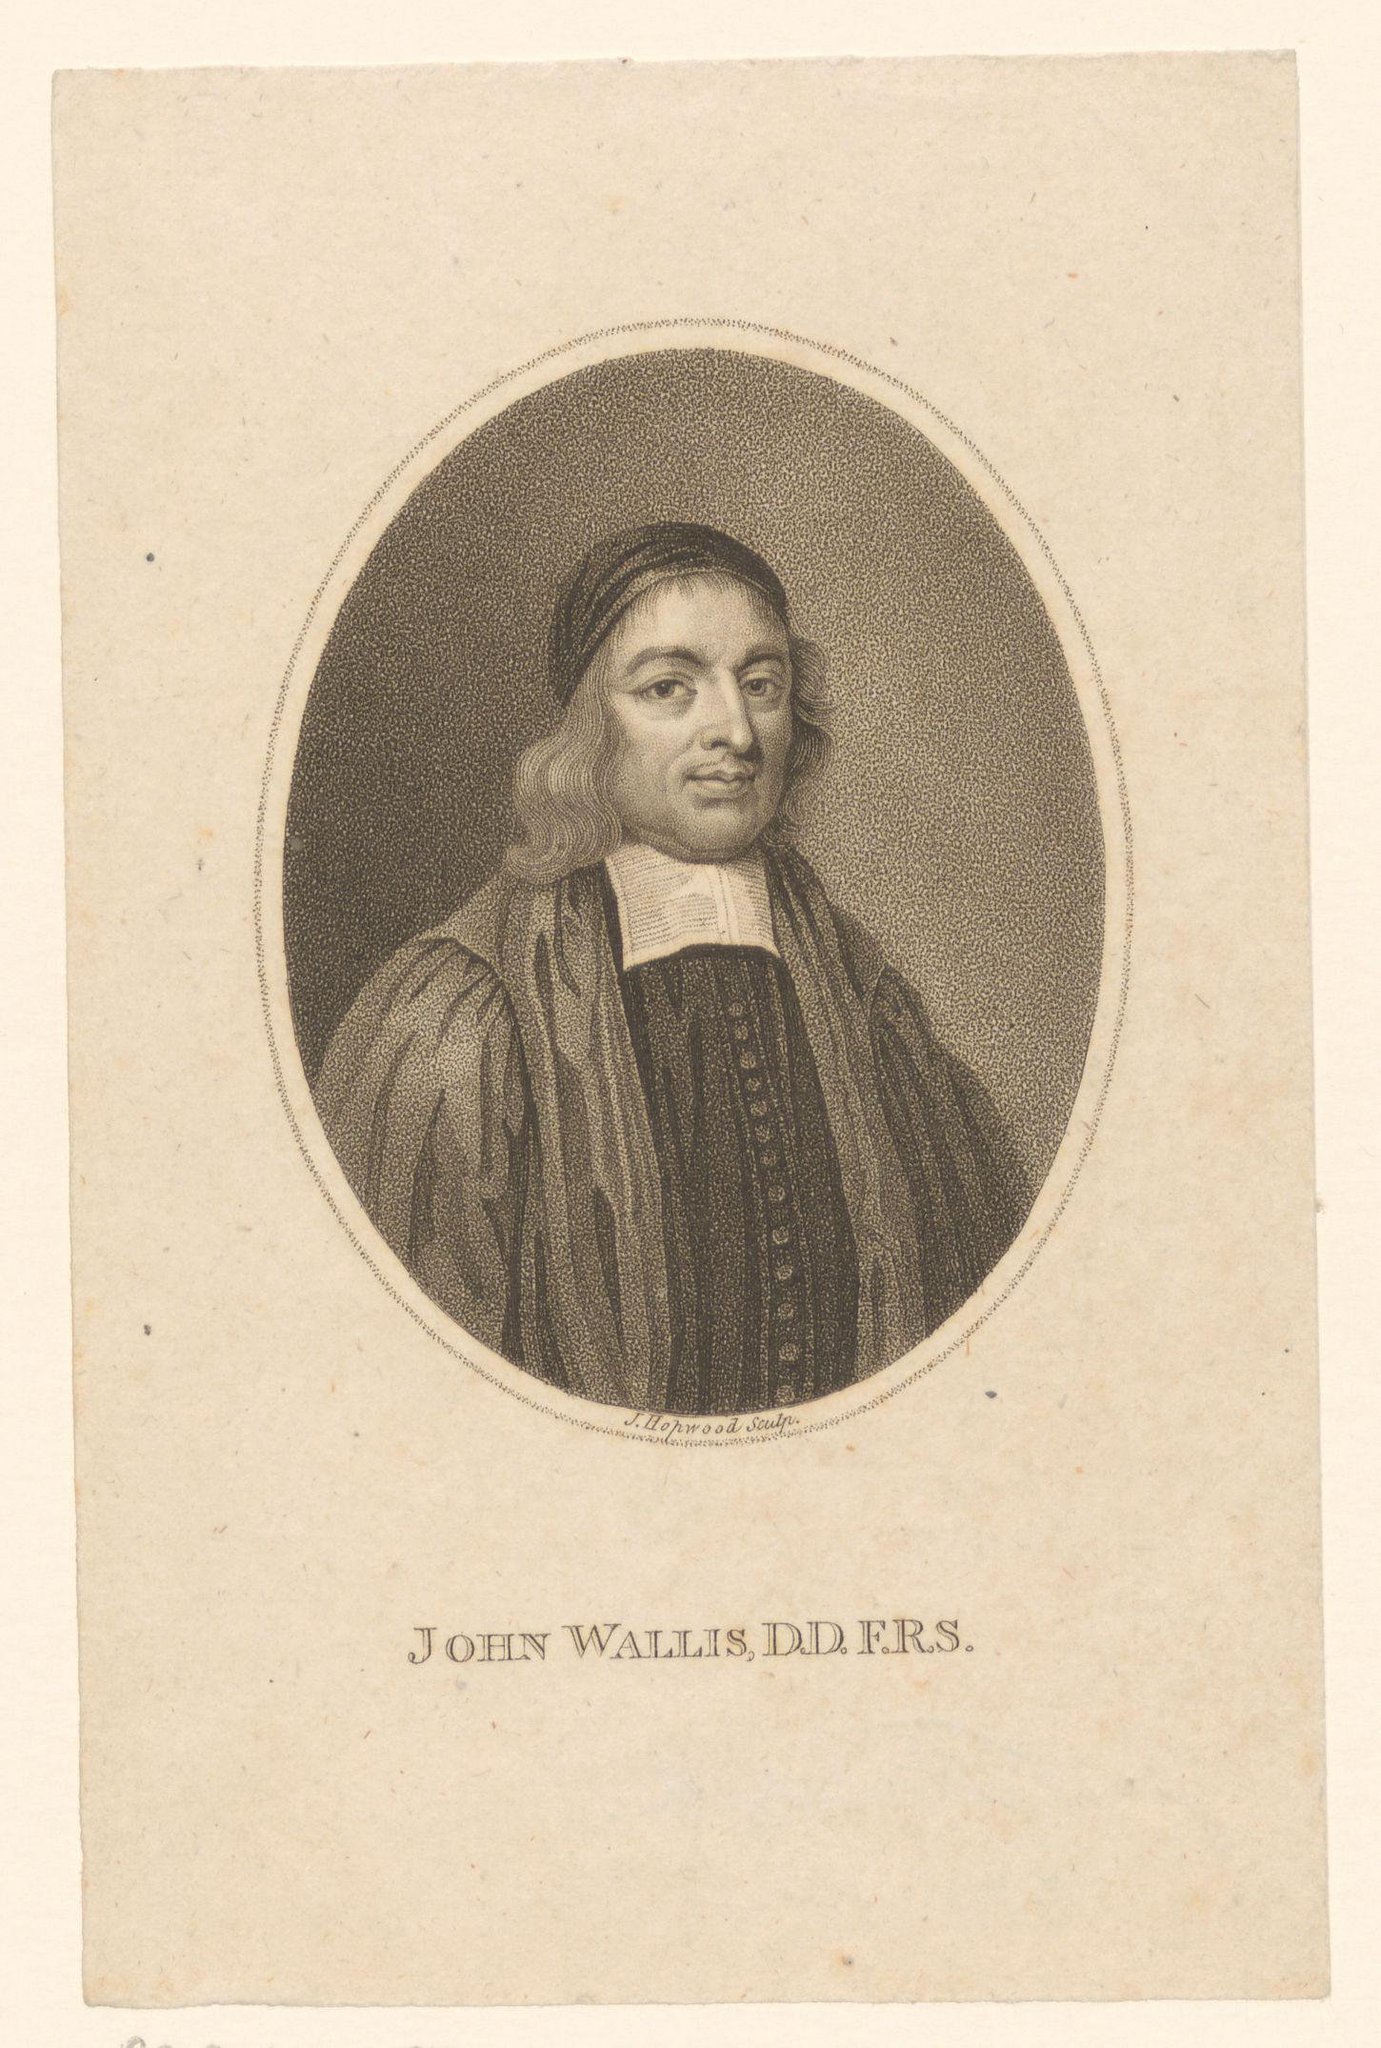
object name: print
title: John Wallis, D.D. F.R.S.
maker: james hopwood (i)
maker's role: print maker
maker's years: 1752-1819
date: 1762-1819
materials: paper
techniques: engraving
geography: england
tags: historical persons, mathematics (+ portrait of scholar, scientist)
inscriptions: collector's mark: Lugt 2228